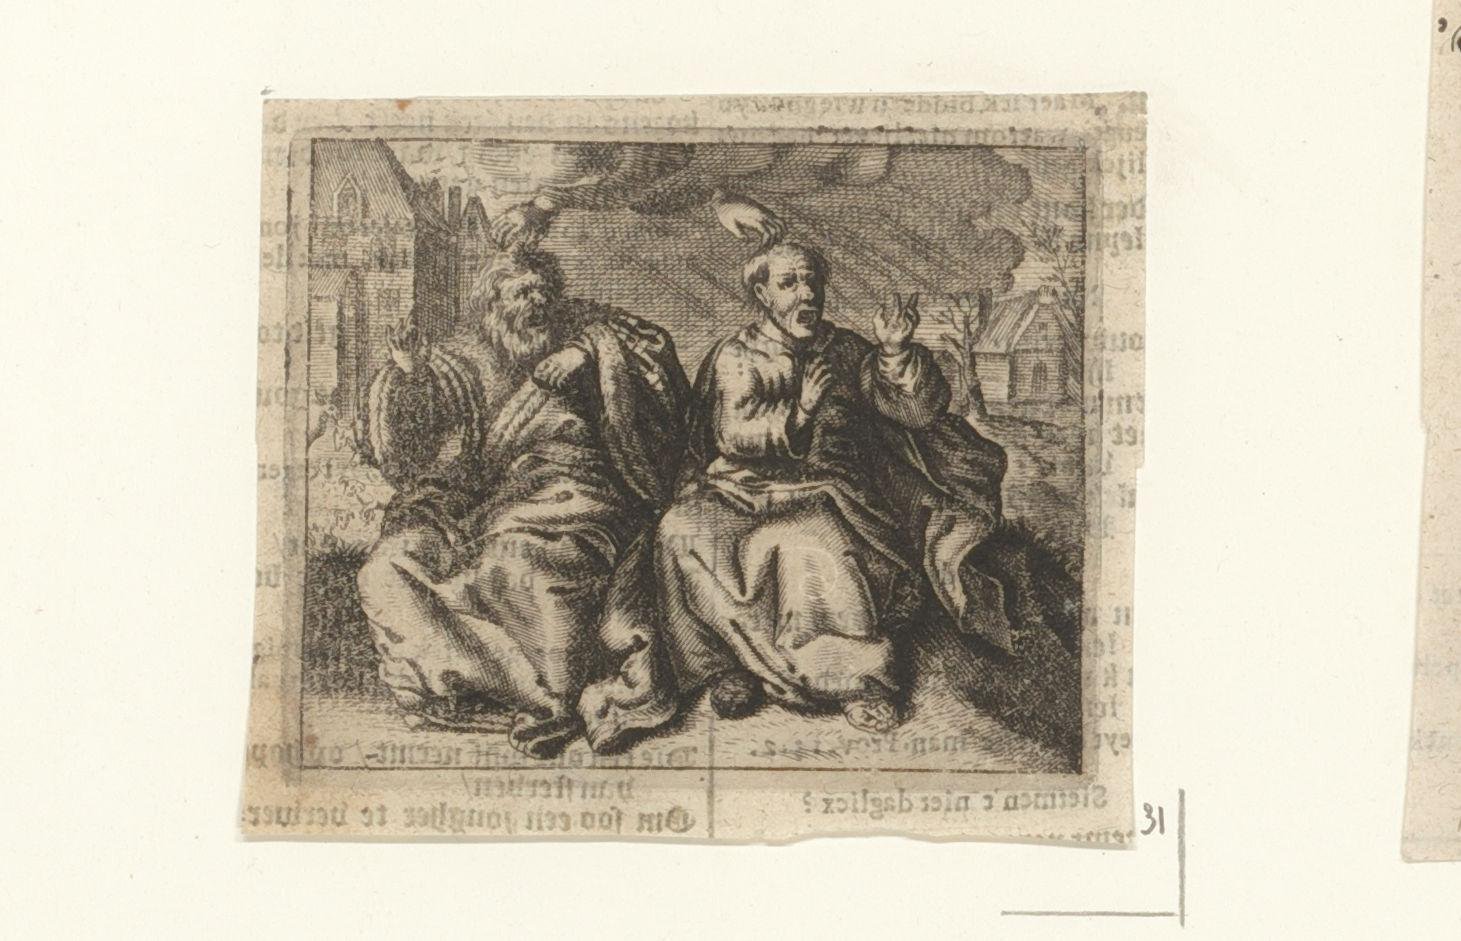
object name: book illustration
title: Twee handen uit de hemel raken de hoofden van twee mannen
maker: Anonymous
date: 1635-1715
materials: paper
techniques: engraving, letterpress printing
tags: clouds, hand, old man, proverbs, sayings, etc.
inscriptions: collector's mark: Lugt 1641, stamp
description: Veel versies van dit embleem verschenen in verschillende uitgave van Spiegel van den Ouden ende Nieuwen Tydt. Zoals: Cats, Jacob. Spiegel van den Ouden ende Nieuwen-tijt, Bestaende uyt Spreeck-woorden (...). Dordrecht: Jacob Braat, 1647. Maar ook in andere publicaties (1665, 1671, 1715, 1722).